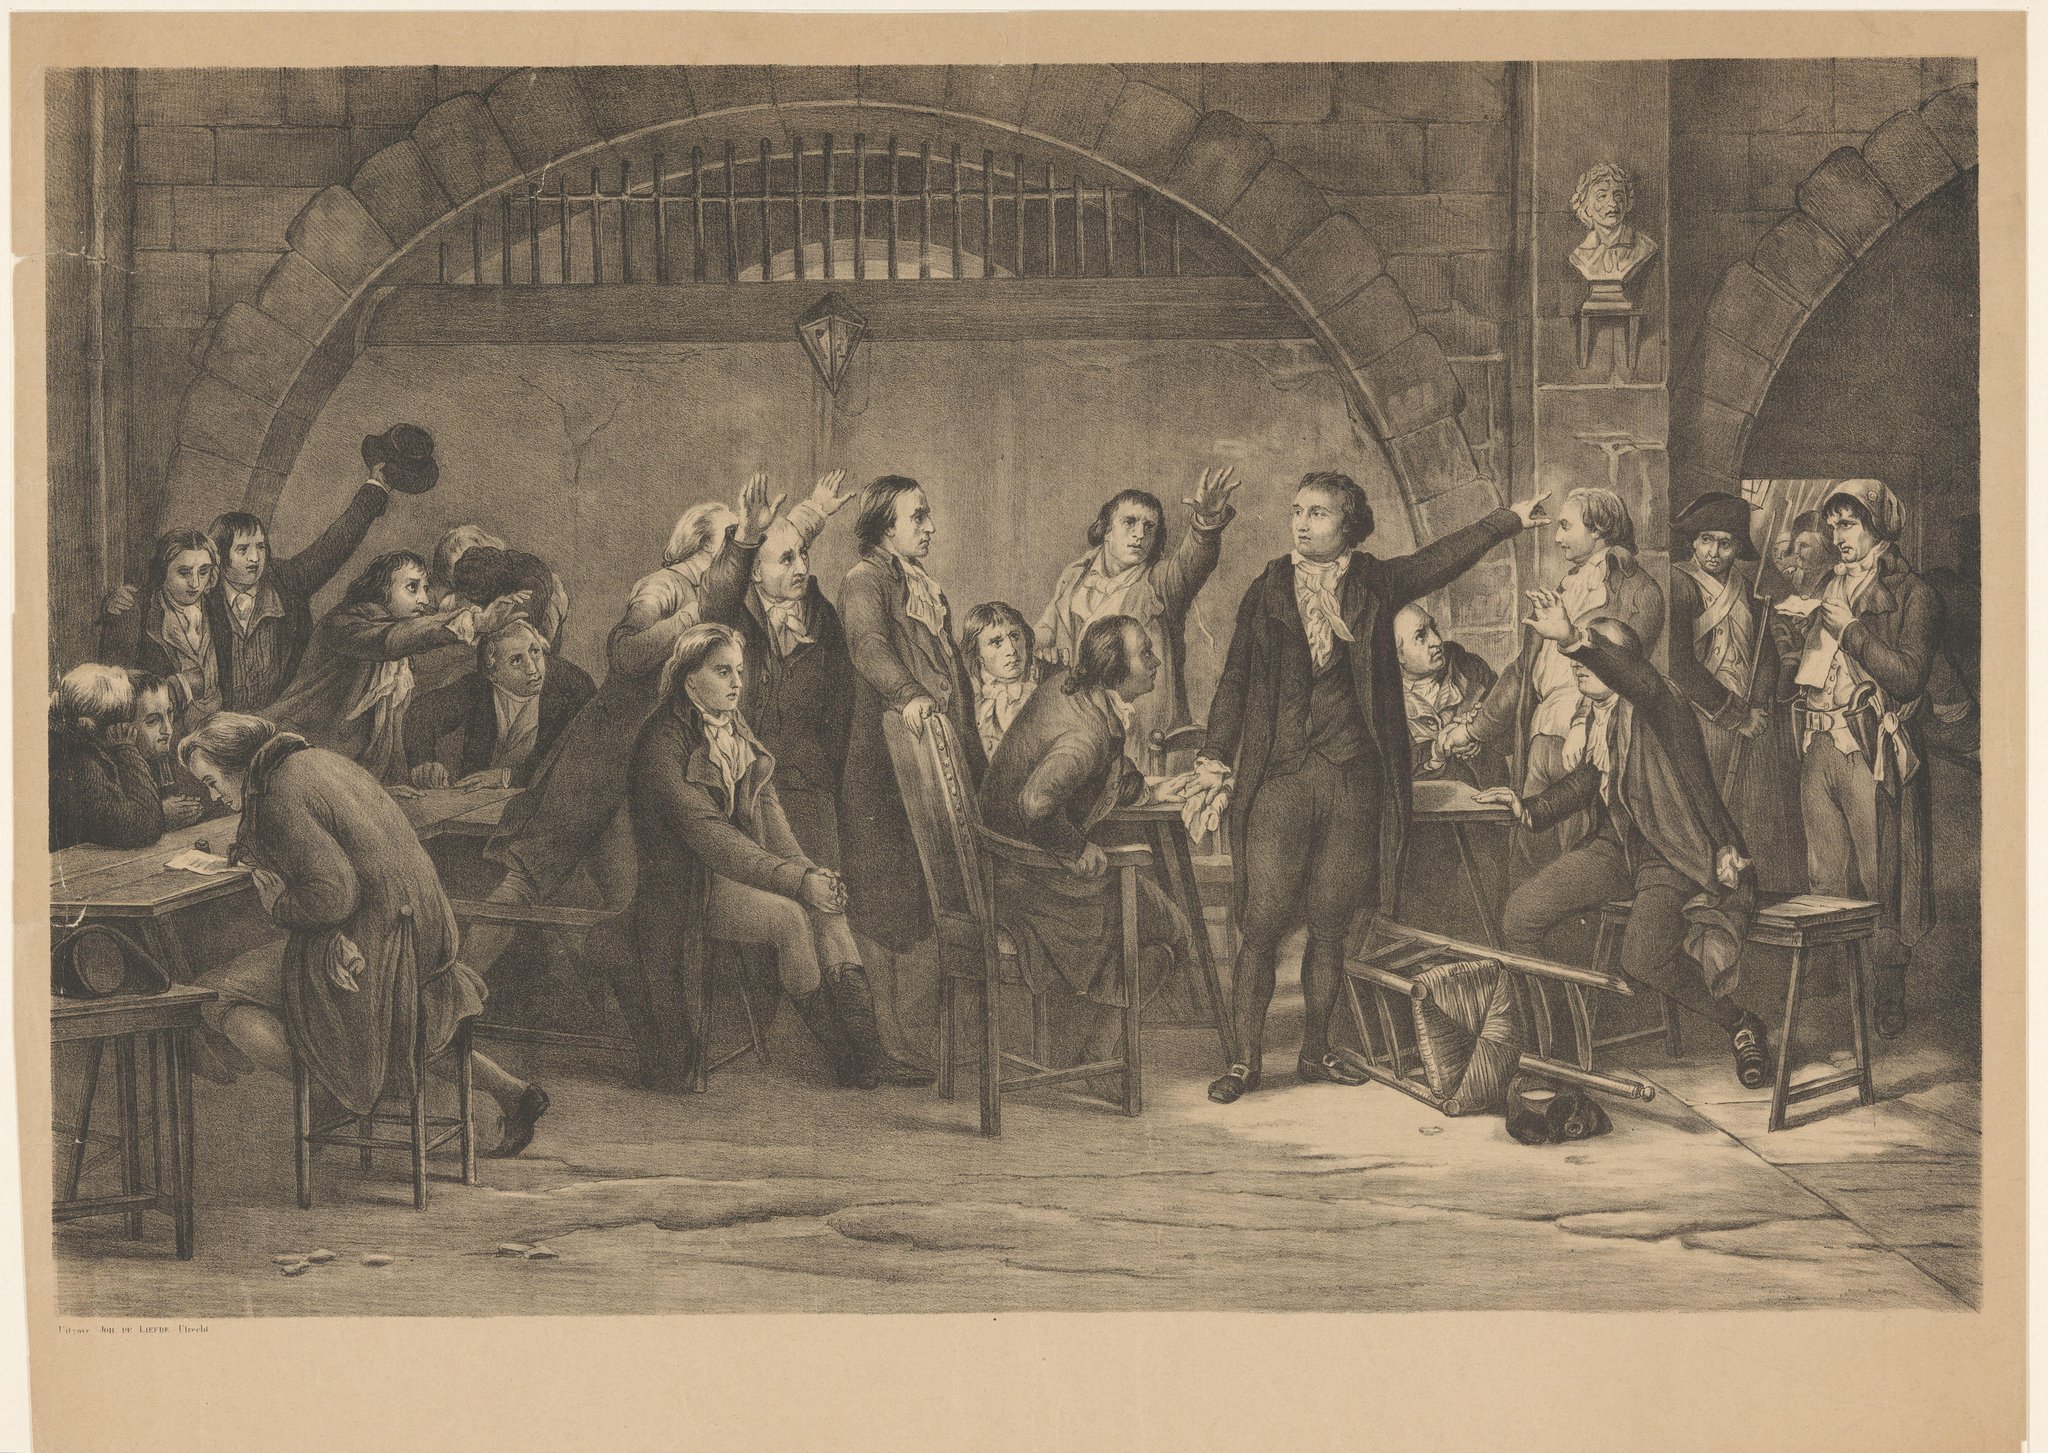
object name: print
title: Gevangenneming der Girondijnen 1793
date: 1850-1890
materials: paper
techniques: lithograph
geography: netherlands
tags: death penalty, execution, despair (of person under sentence of death), prisoner in cell or locked place, paris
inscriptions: collector's mark: Lugt 2228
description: Groep girondijnen in een gevangeniscel in de Conciergerie, op het moment dat ze hun doodvonnis vernemen, 1793.